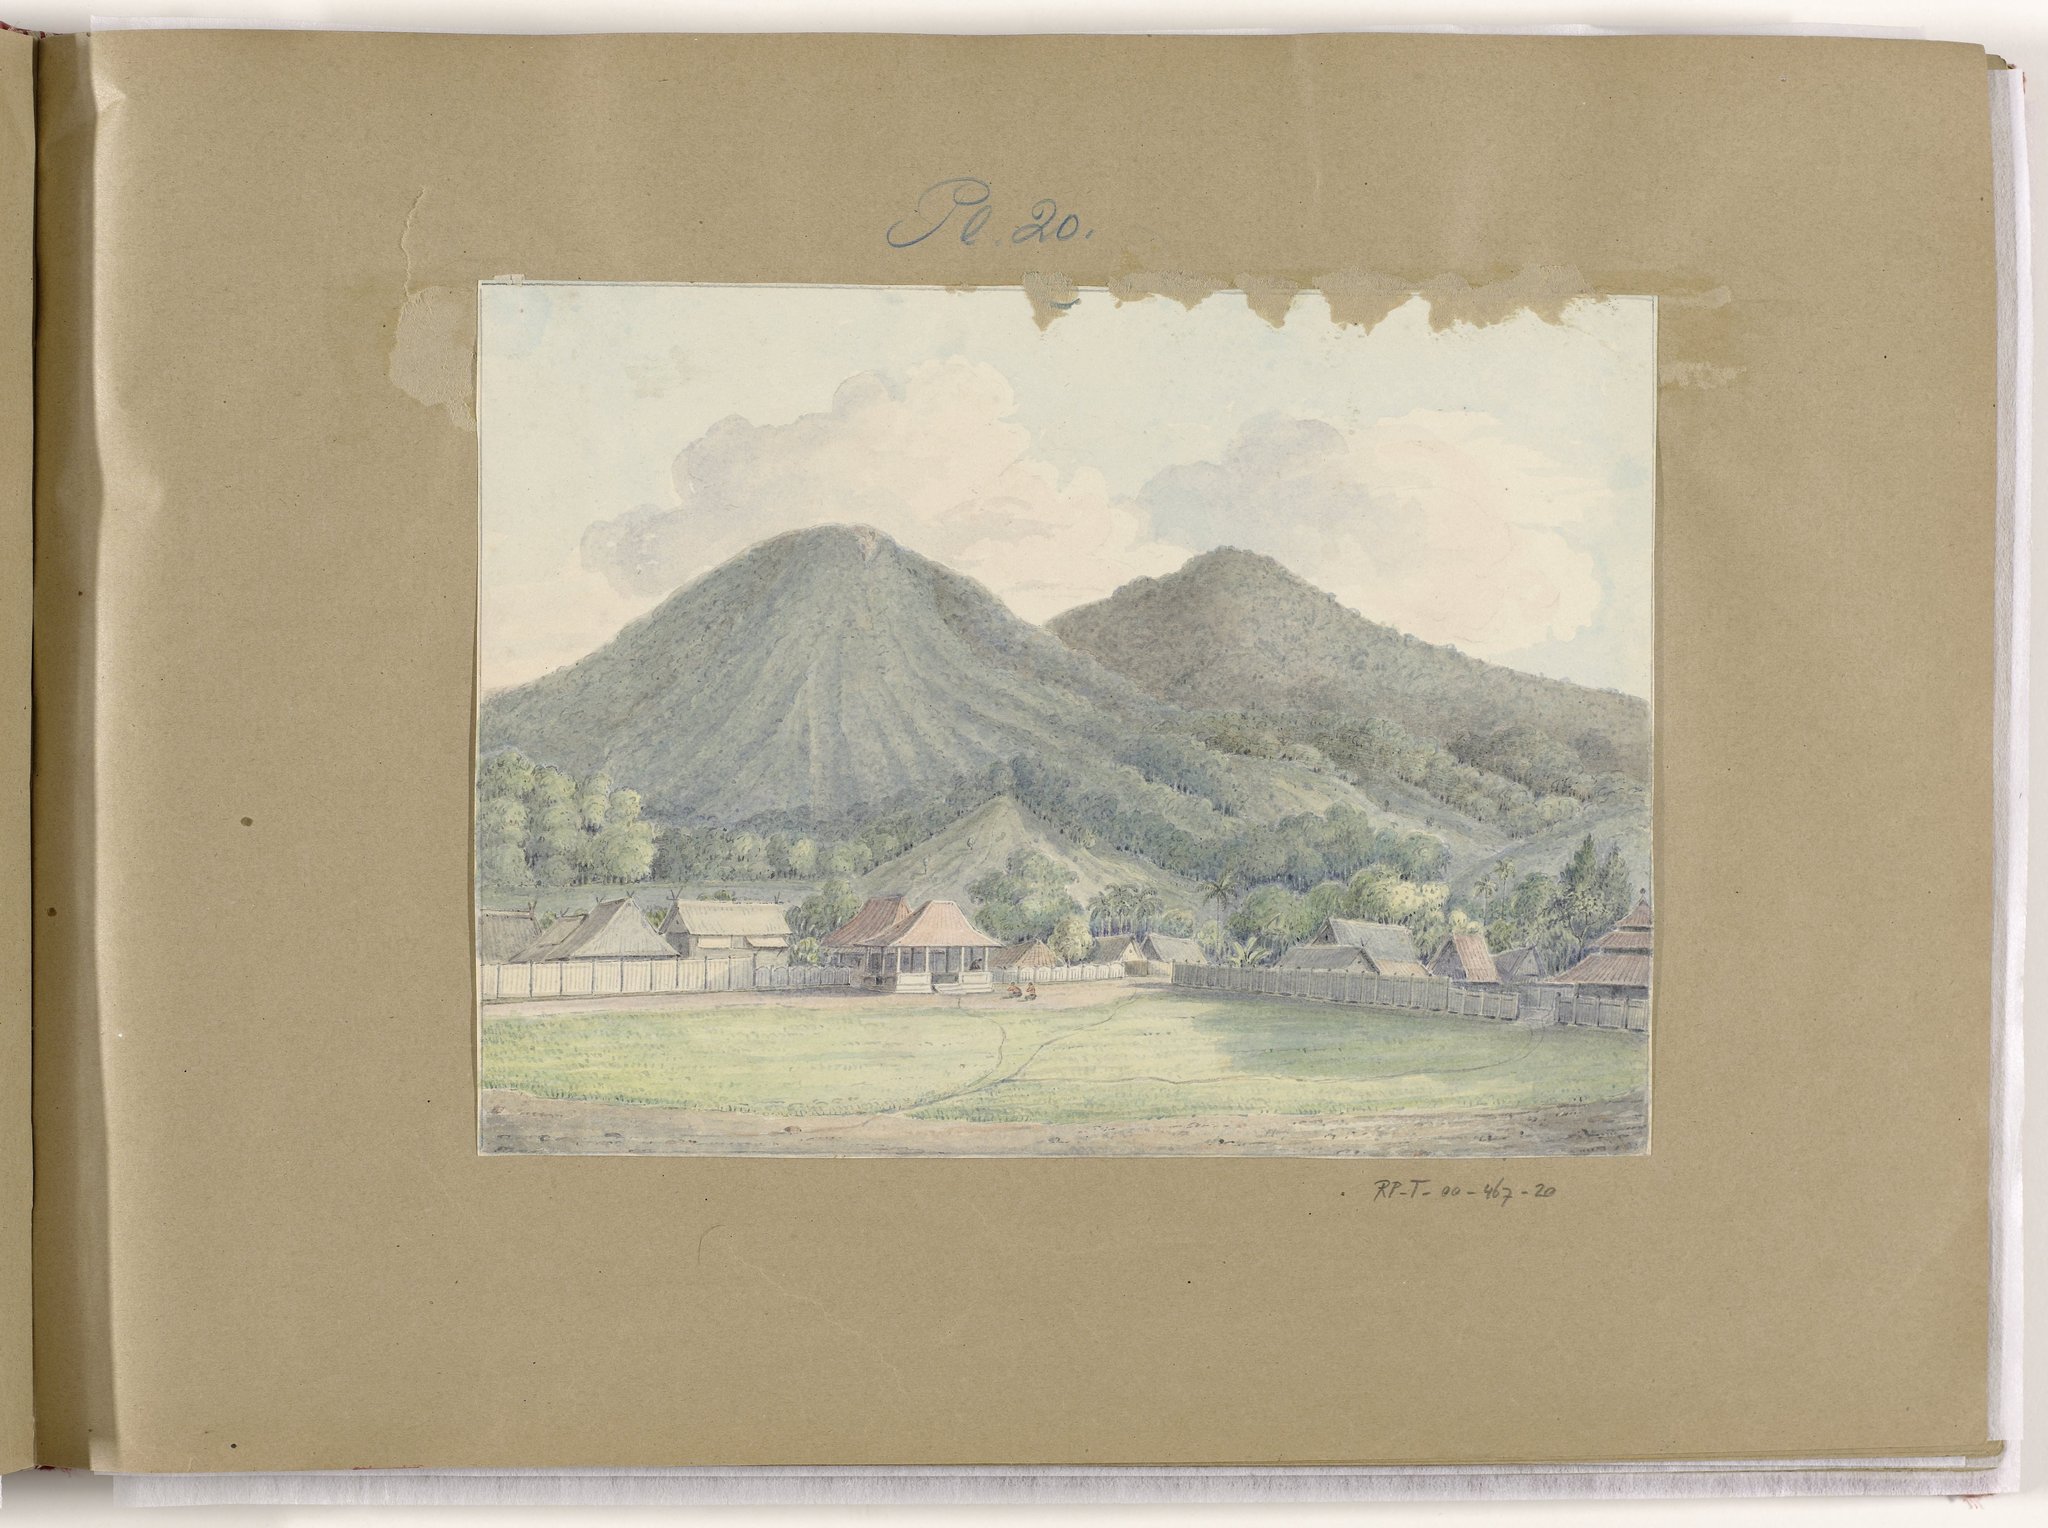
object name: drawing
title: Preanger regentschappen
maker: jannes theodorus bik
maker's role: draughtsman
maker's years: 1796-1872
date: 1819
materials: paper, watercolor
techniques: brush, pen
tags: city-view, and landscape with man-made constructions, landscapes in the temperate zone, cultivated land, mountains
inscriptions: inscription: ‘Negory Lelles Preanger regentschappen J.T. Bik 1819’